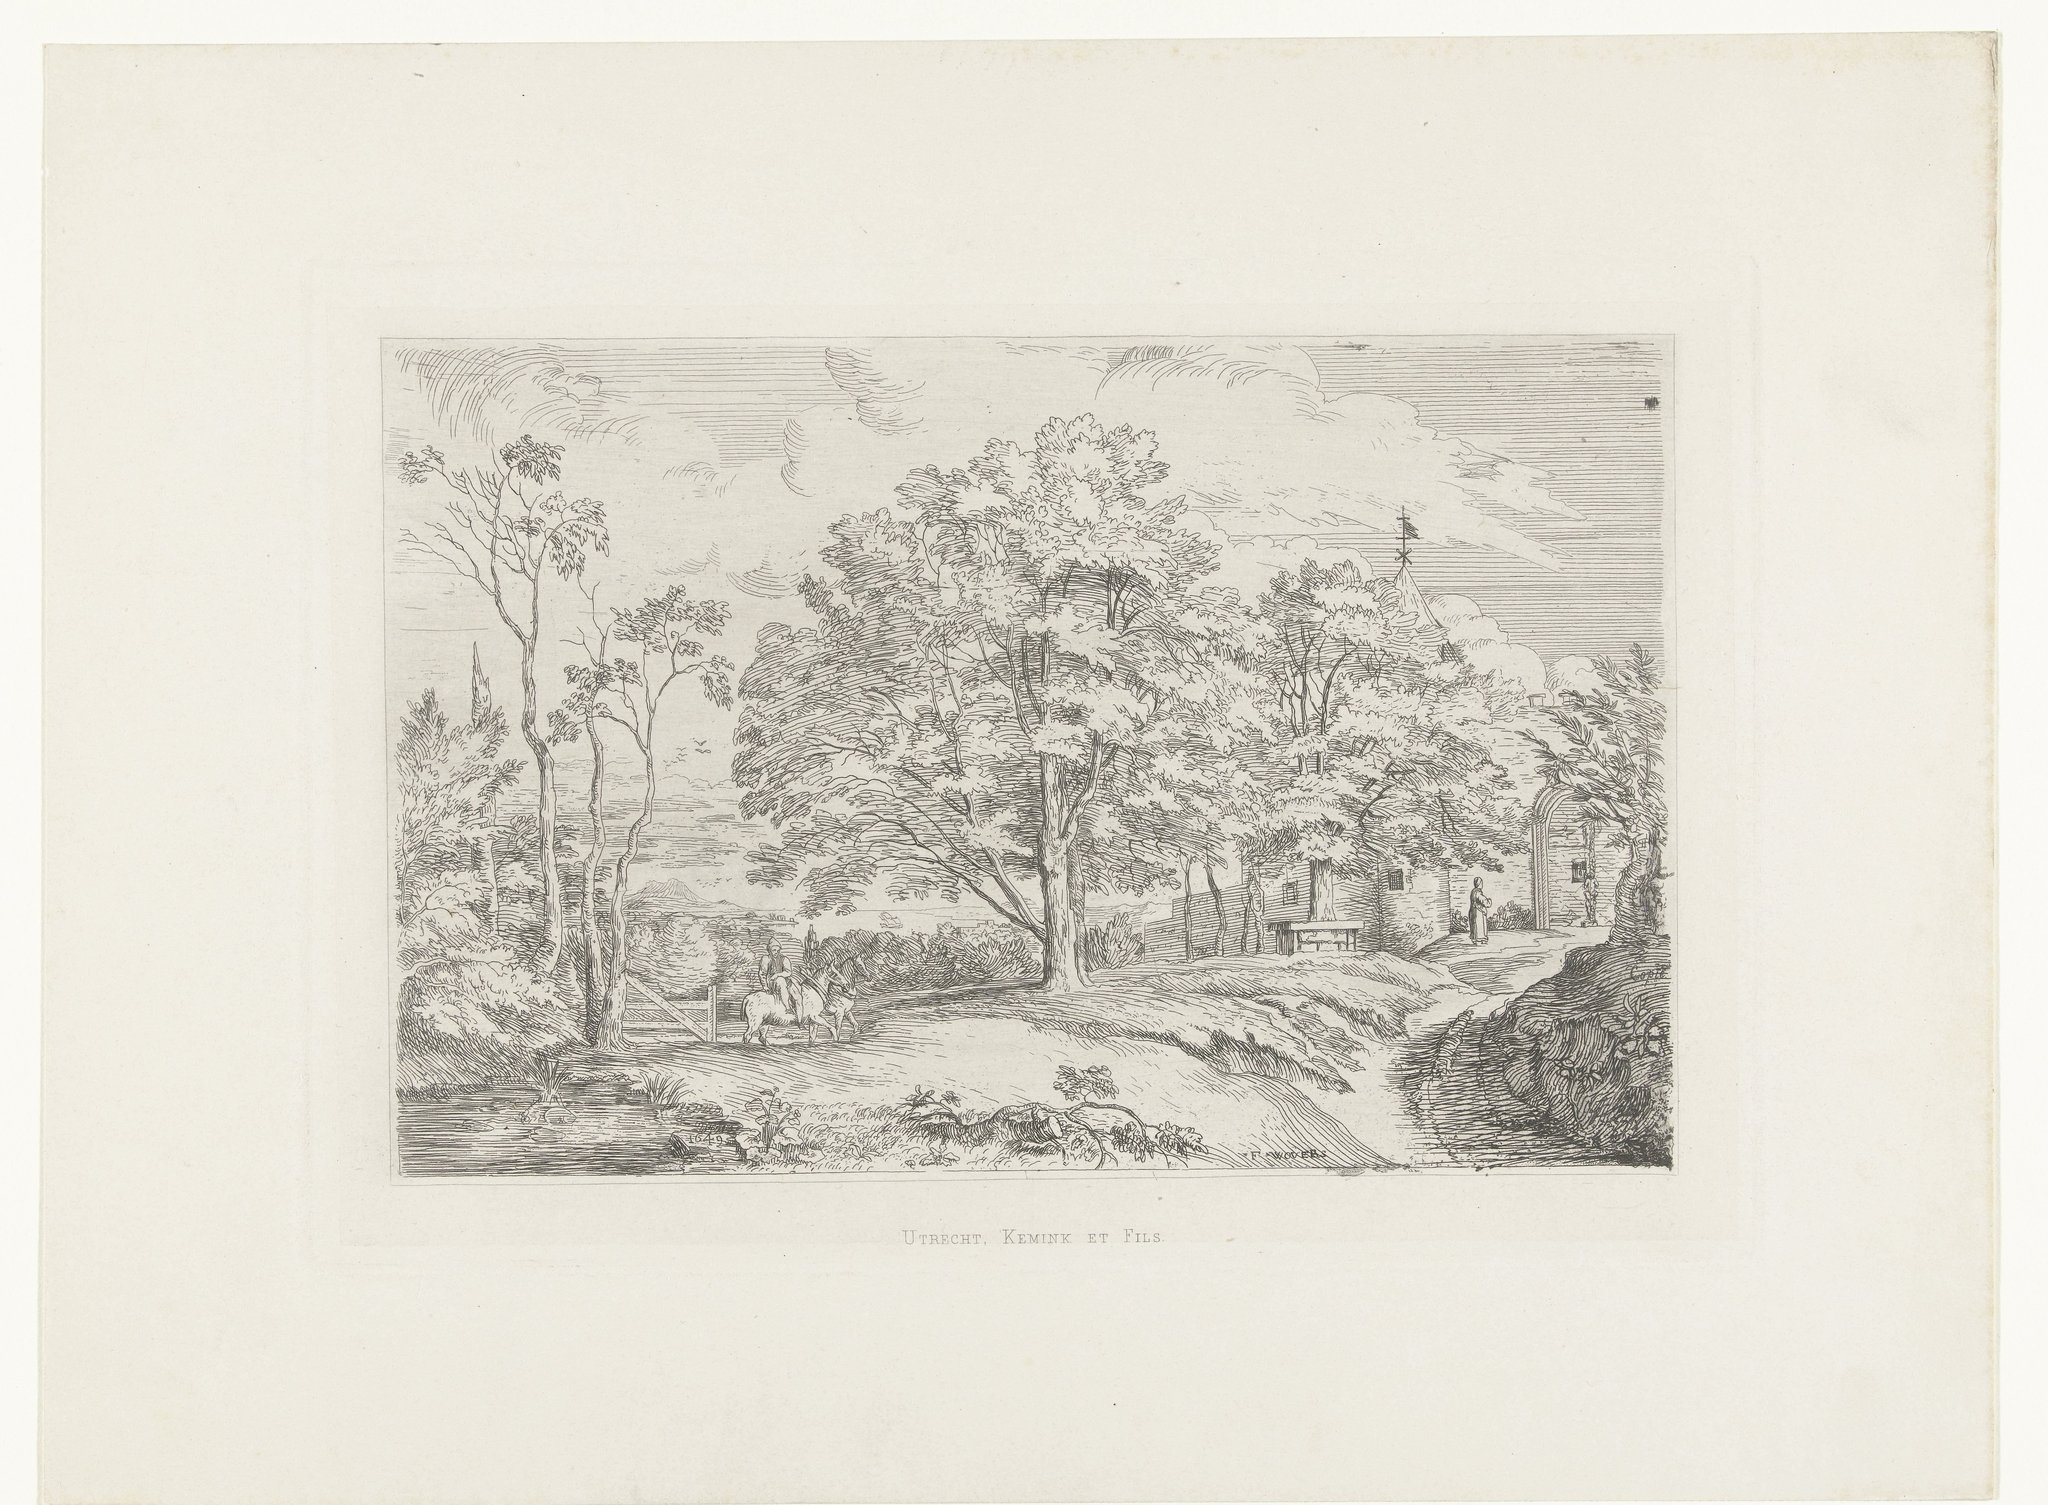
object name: print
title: Landschap met ruiter op weg naar een kasteel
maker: johannes arnoldus boland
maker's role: print maker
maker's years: 1838-1922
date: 1866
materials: paper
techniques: etching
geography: utrecht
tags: landscapes in the temperate zone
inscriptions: collector's mark: Lugt 2228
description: Illustratie voor J.P. van der Kellen, Le peintre graveur hollandais et flamand, Utrecht: 1866.